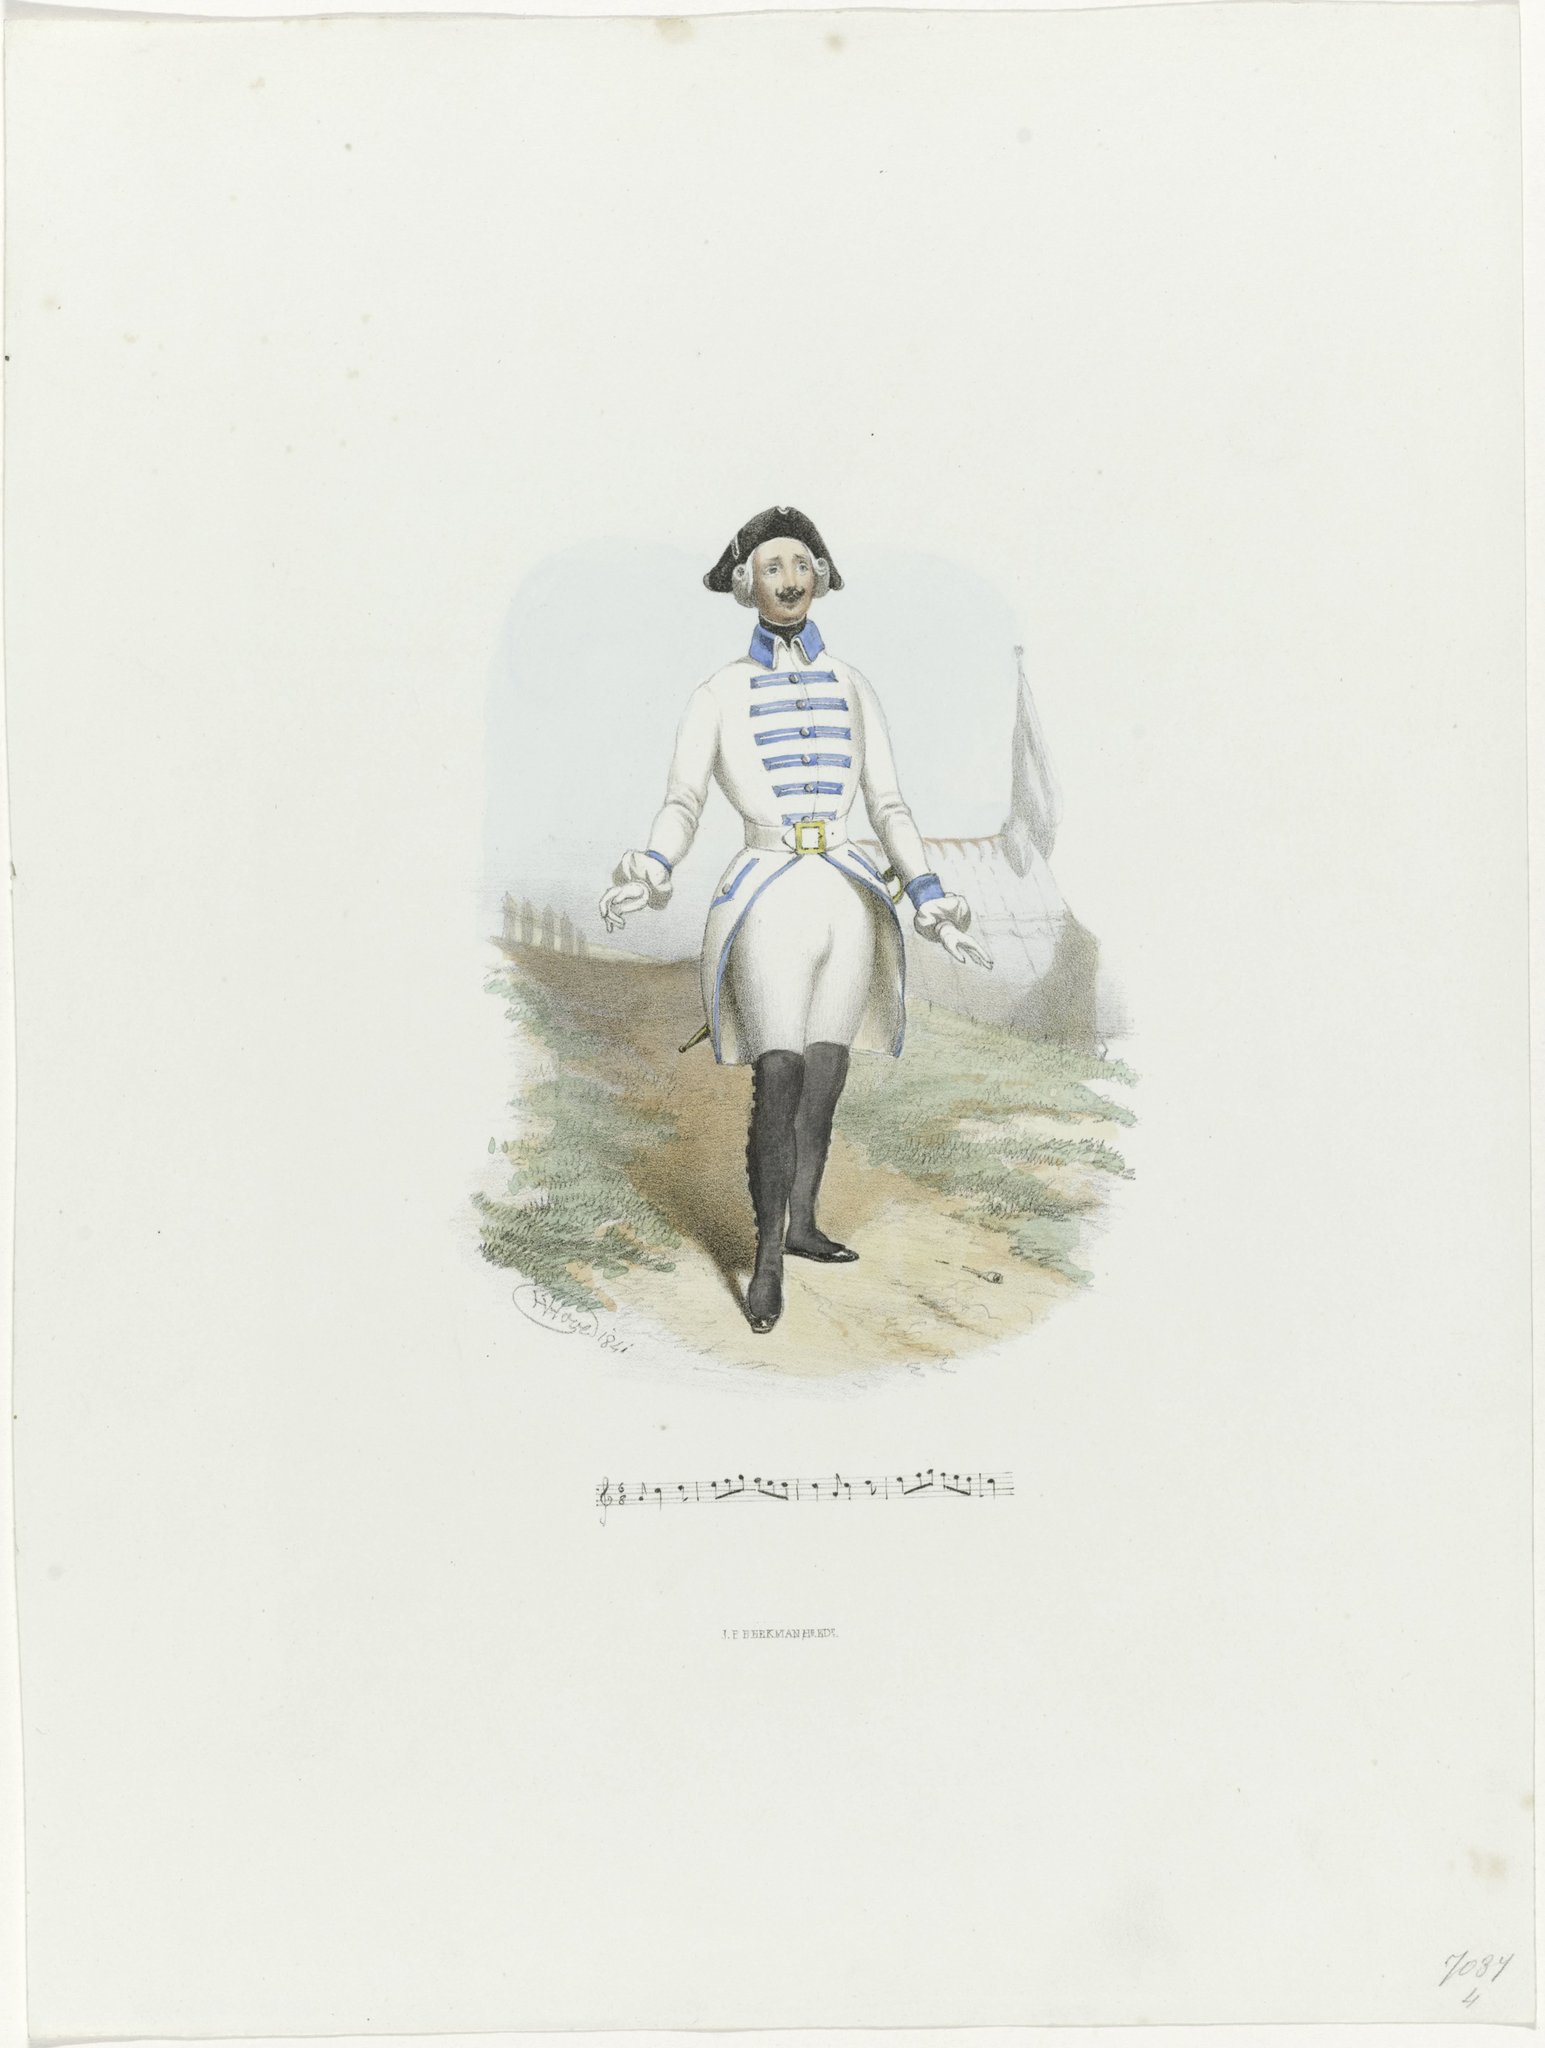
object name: costume print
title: Album van het Gekostumeerd Bal, 17 en 19 February 1841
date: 1841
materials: paper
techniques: hand coloring, lithograph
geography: netherlands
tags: anna paulowna romanowa, william ii of the netherlands, notation of music, historical costume, the hague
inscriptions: collector's mark: Lugt 2228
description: Man in historisch kostuum van een Pruisische officier, mogelijk in een zingende rol. Onderaan een muziekbalk met noten. Zie pendant. Onderdeel van het album bestaande uit een omslag en zes platen van kostuums gedragen op het gekostumeerde bal gehouden te Den Haag op 17 en 19 februari 1841 ter gelegenheid van het 25-jarig huwelijk van koning Willem II en Anna Paulowna.